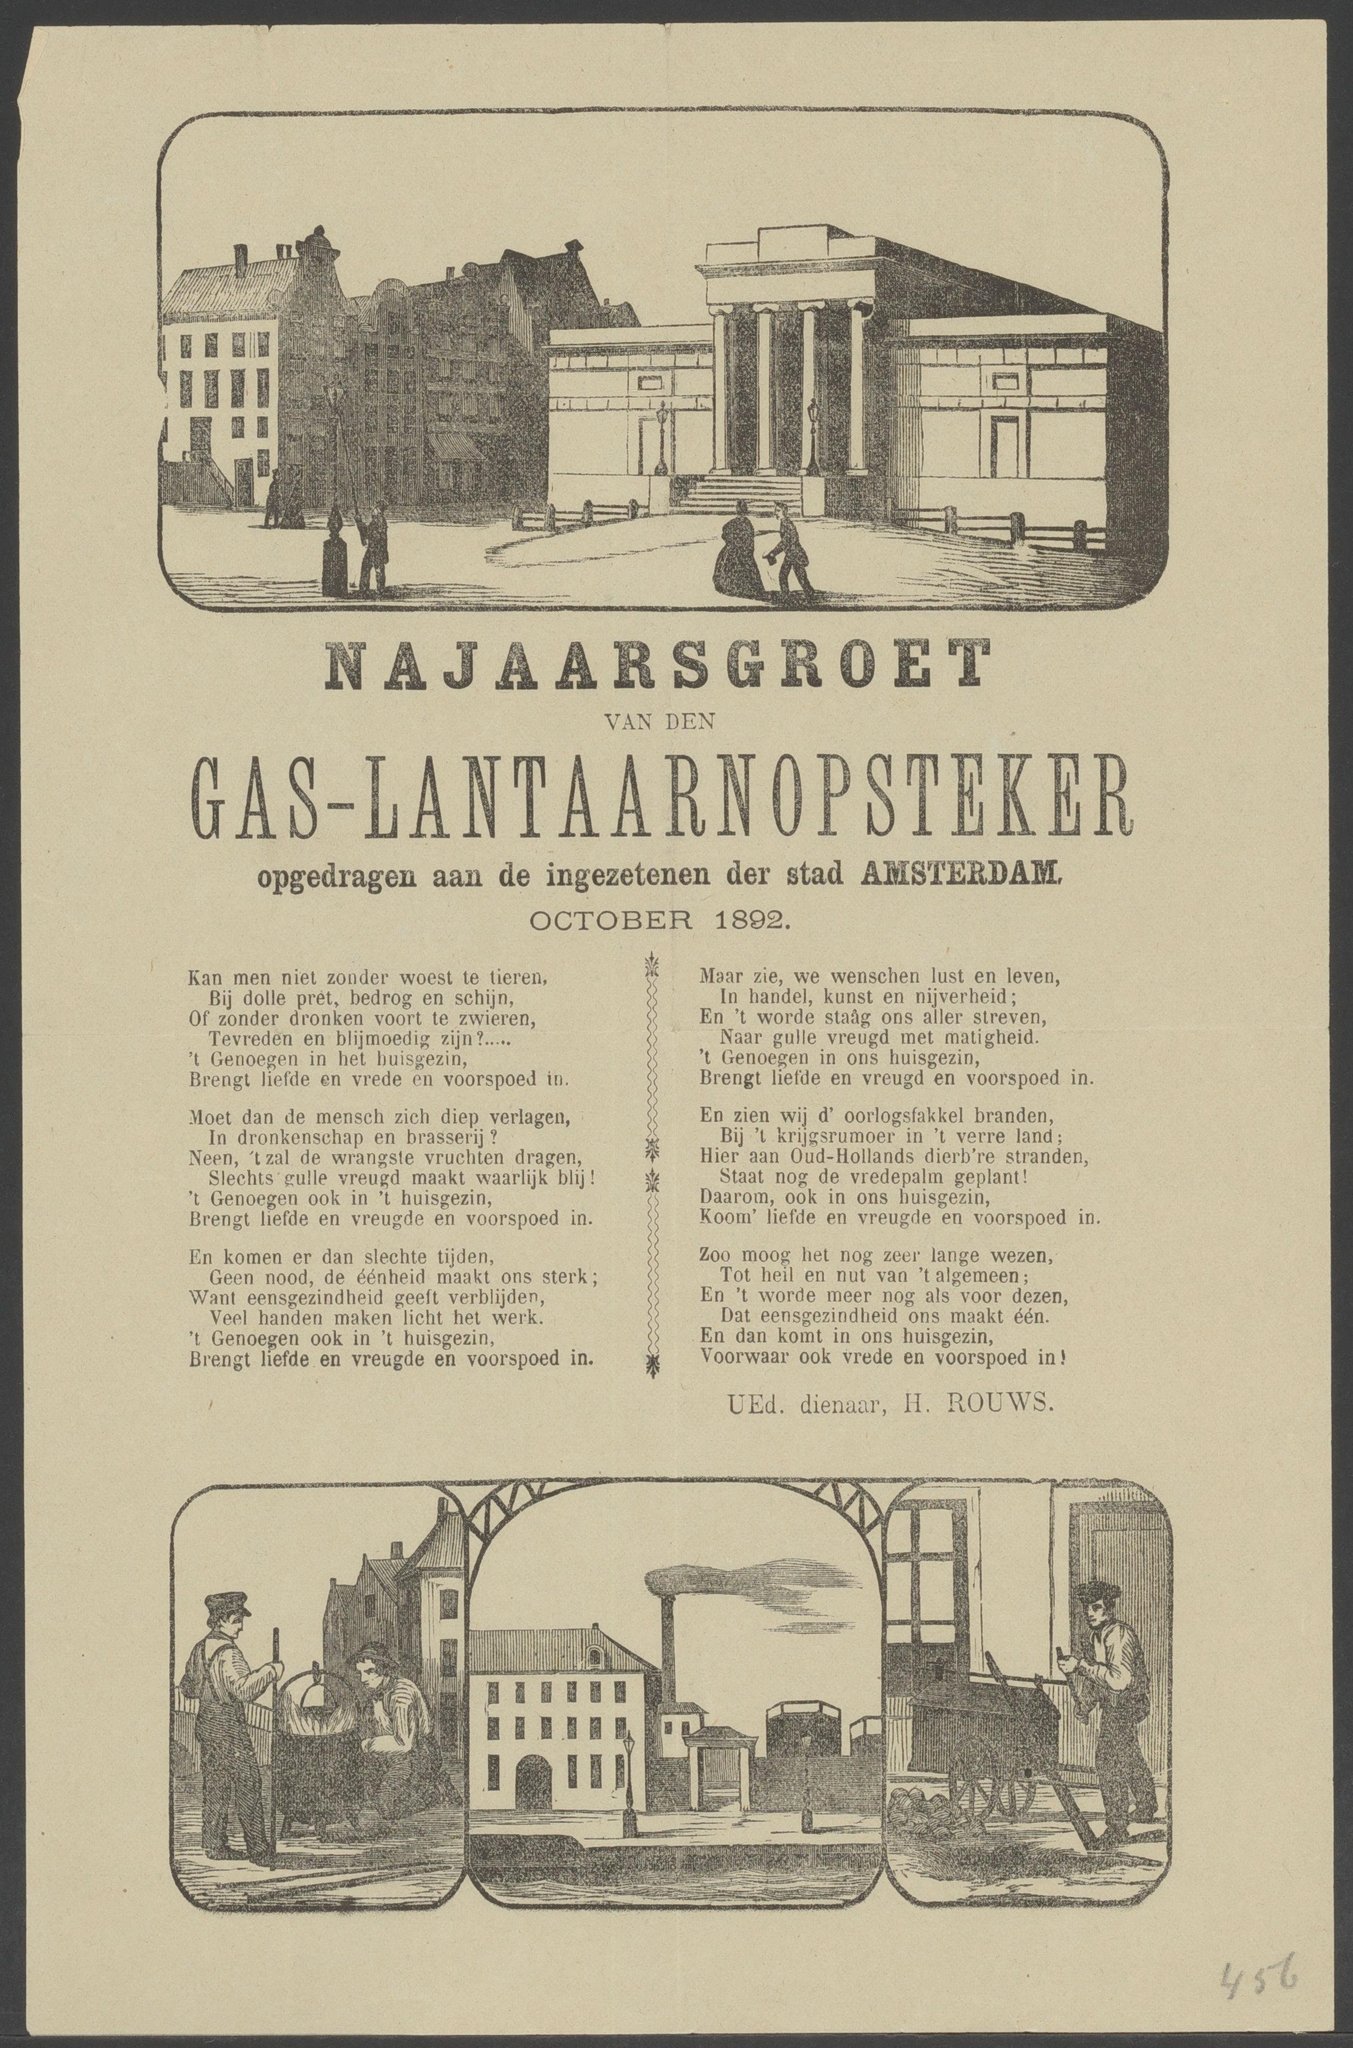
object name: print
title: Kermiswens van de gaslantaarnopstekers van Amsterdam voor het jaar 1892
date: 1892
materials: paper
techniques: letterpress printing, engraving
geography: amsterdam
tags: gas-lamp, gas supply, digging (industrial process), street lighting, amsterdam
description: Kermiswens van de Amsterdamse gaslantaarnopstekers voor het jaar 1892. Centraal een vers in twee kolommen. Bovenaan de Dam met de beurs van Zocher te Amsterdam. Onderaan de Hollandsche Gasfabriek en twee gasfitters aan het werk. Van de gaslantaarnopsteker: H. Rouws. Onderwerpsrubrieken binnen de Atlas Zeden en Gewoonten: Zeden en gewoonten in engeren zin, Volksleven, Volksbladen, Nieuwjaars- en Kerstwenschen, Amsterdam.